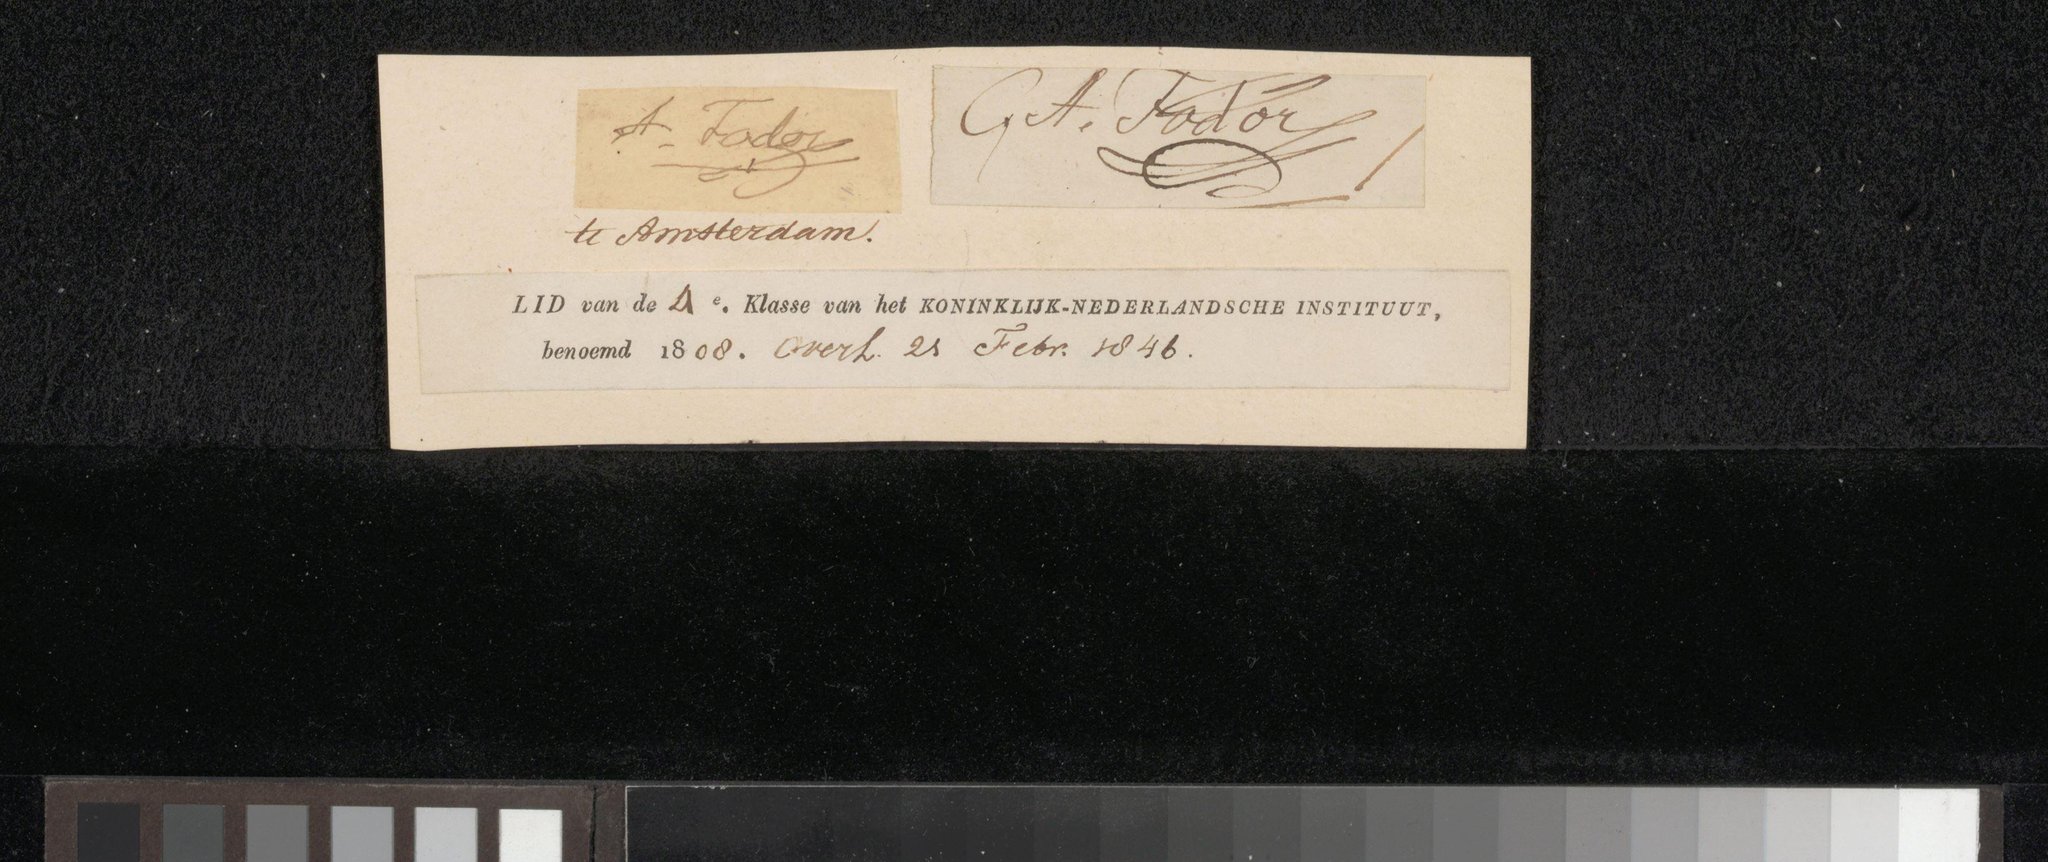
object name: manuscript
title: Handtekeningen van Carel Anton Fodor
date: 1789-1847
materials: ink, paper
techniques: pen, printing, writing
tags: carel anton fodor, amsterdam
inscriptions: collector's mark: ‘RPK’